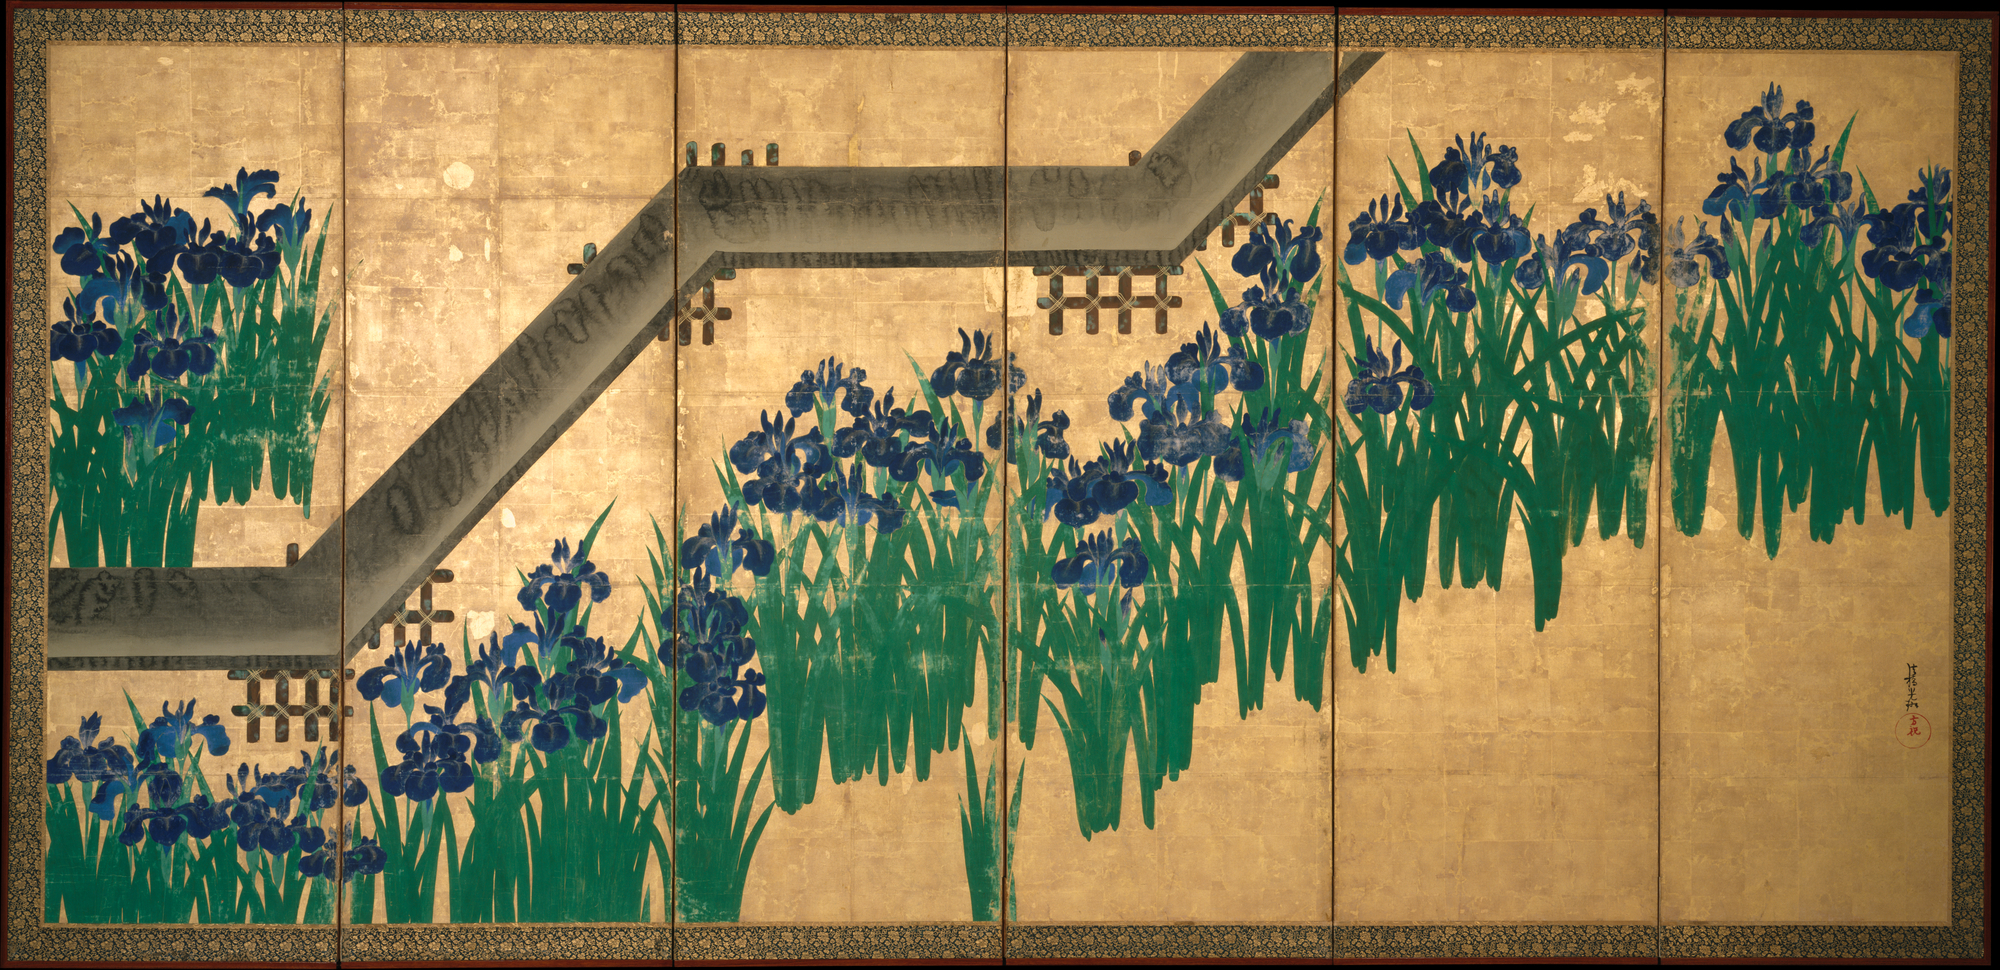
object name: screen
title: Irises at Yatsuhashi (Eight Bridges)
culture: japanese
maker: ogata kōrin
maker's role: artist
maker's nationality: japanese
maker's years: 1658-1716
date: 1709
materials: gold leaf, ink, panel, paper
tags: bridges,flowers